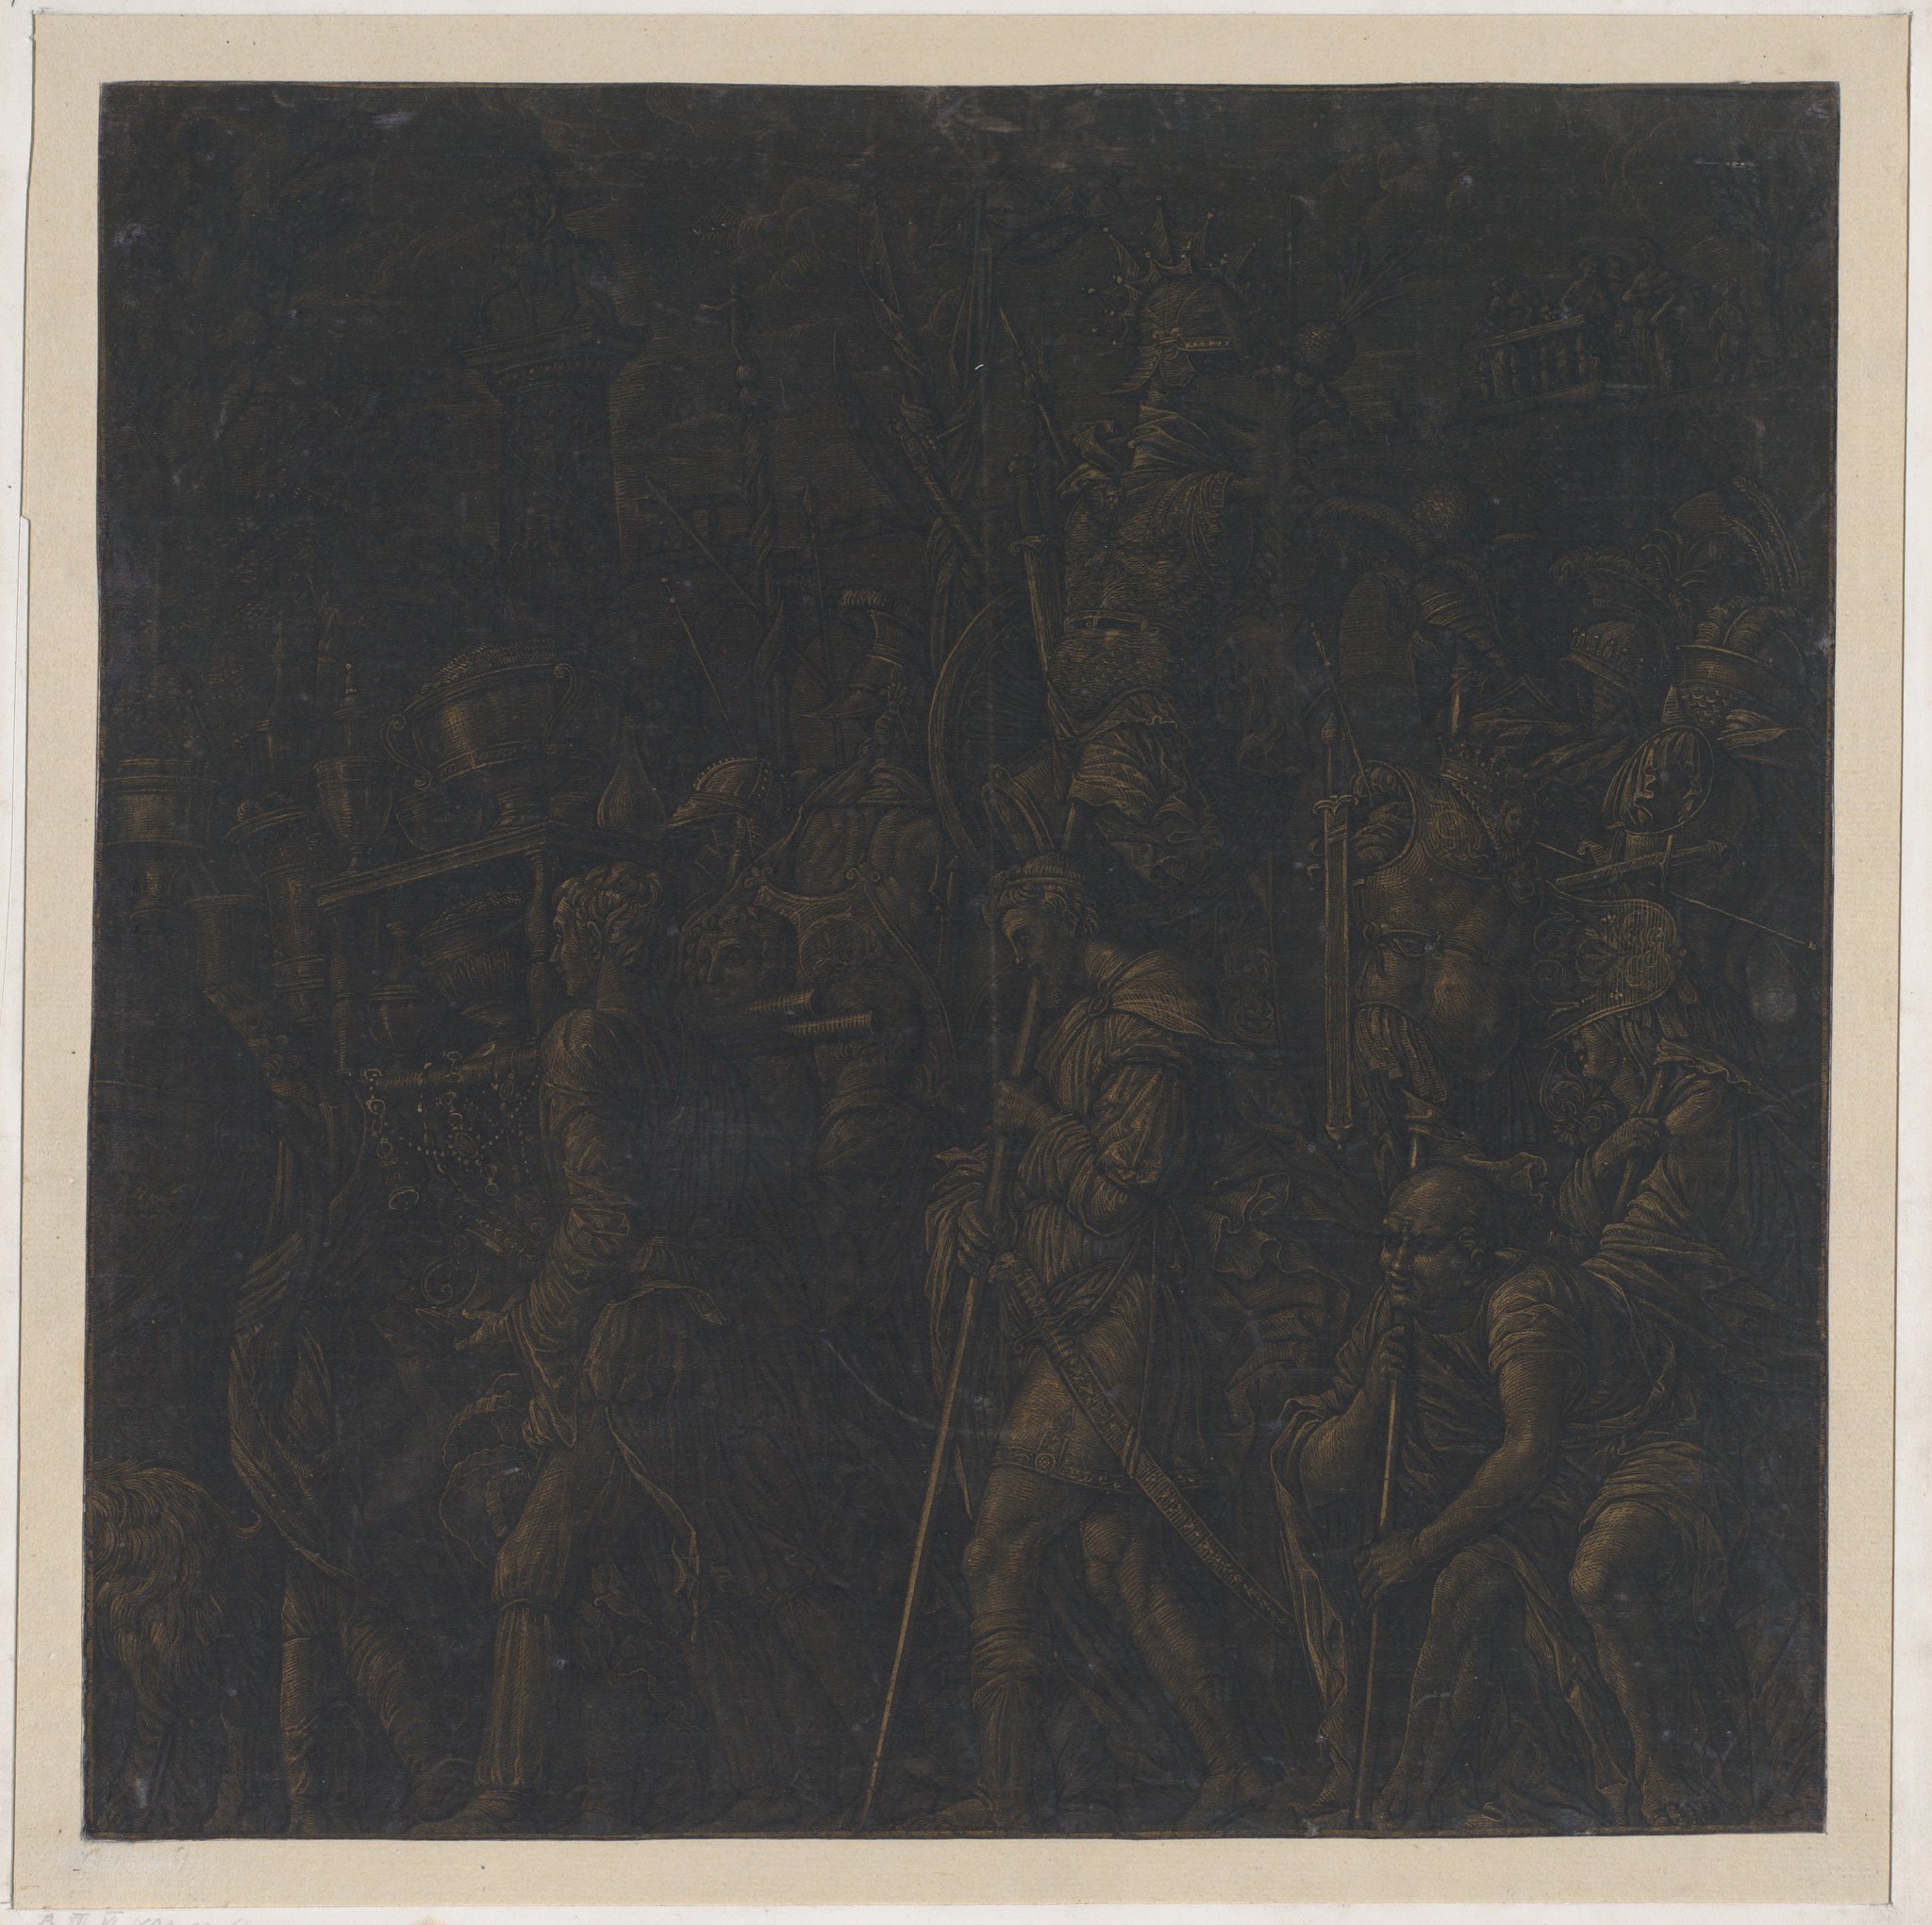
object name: print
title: Sheet 8 from "The Triumphs of Caesar"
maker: andrea andreani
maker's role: artist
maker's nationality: italian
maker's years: 1558-1629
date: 1599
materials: gold, silk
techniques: highlighting, printing, woodcut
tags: men